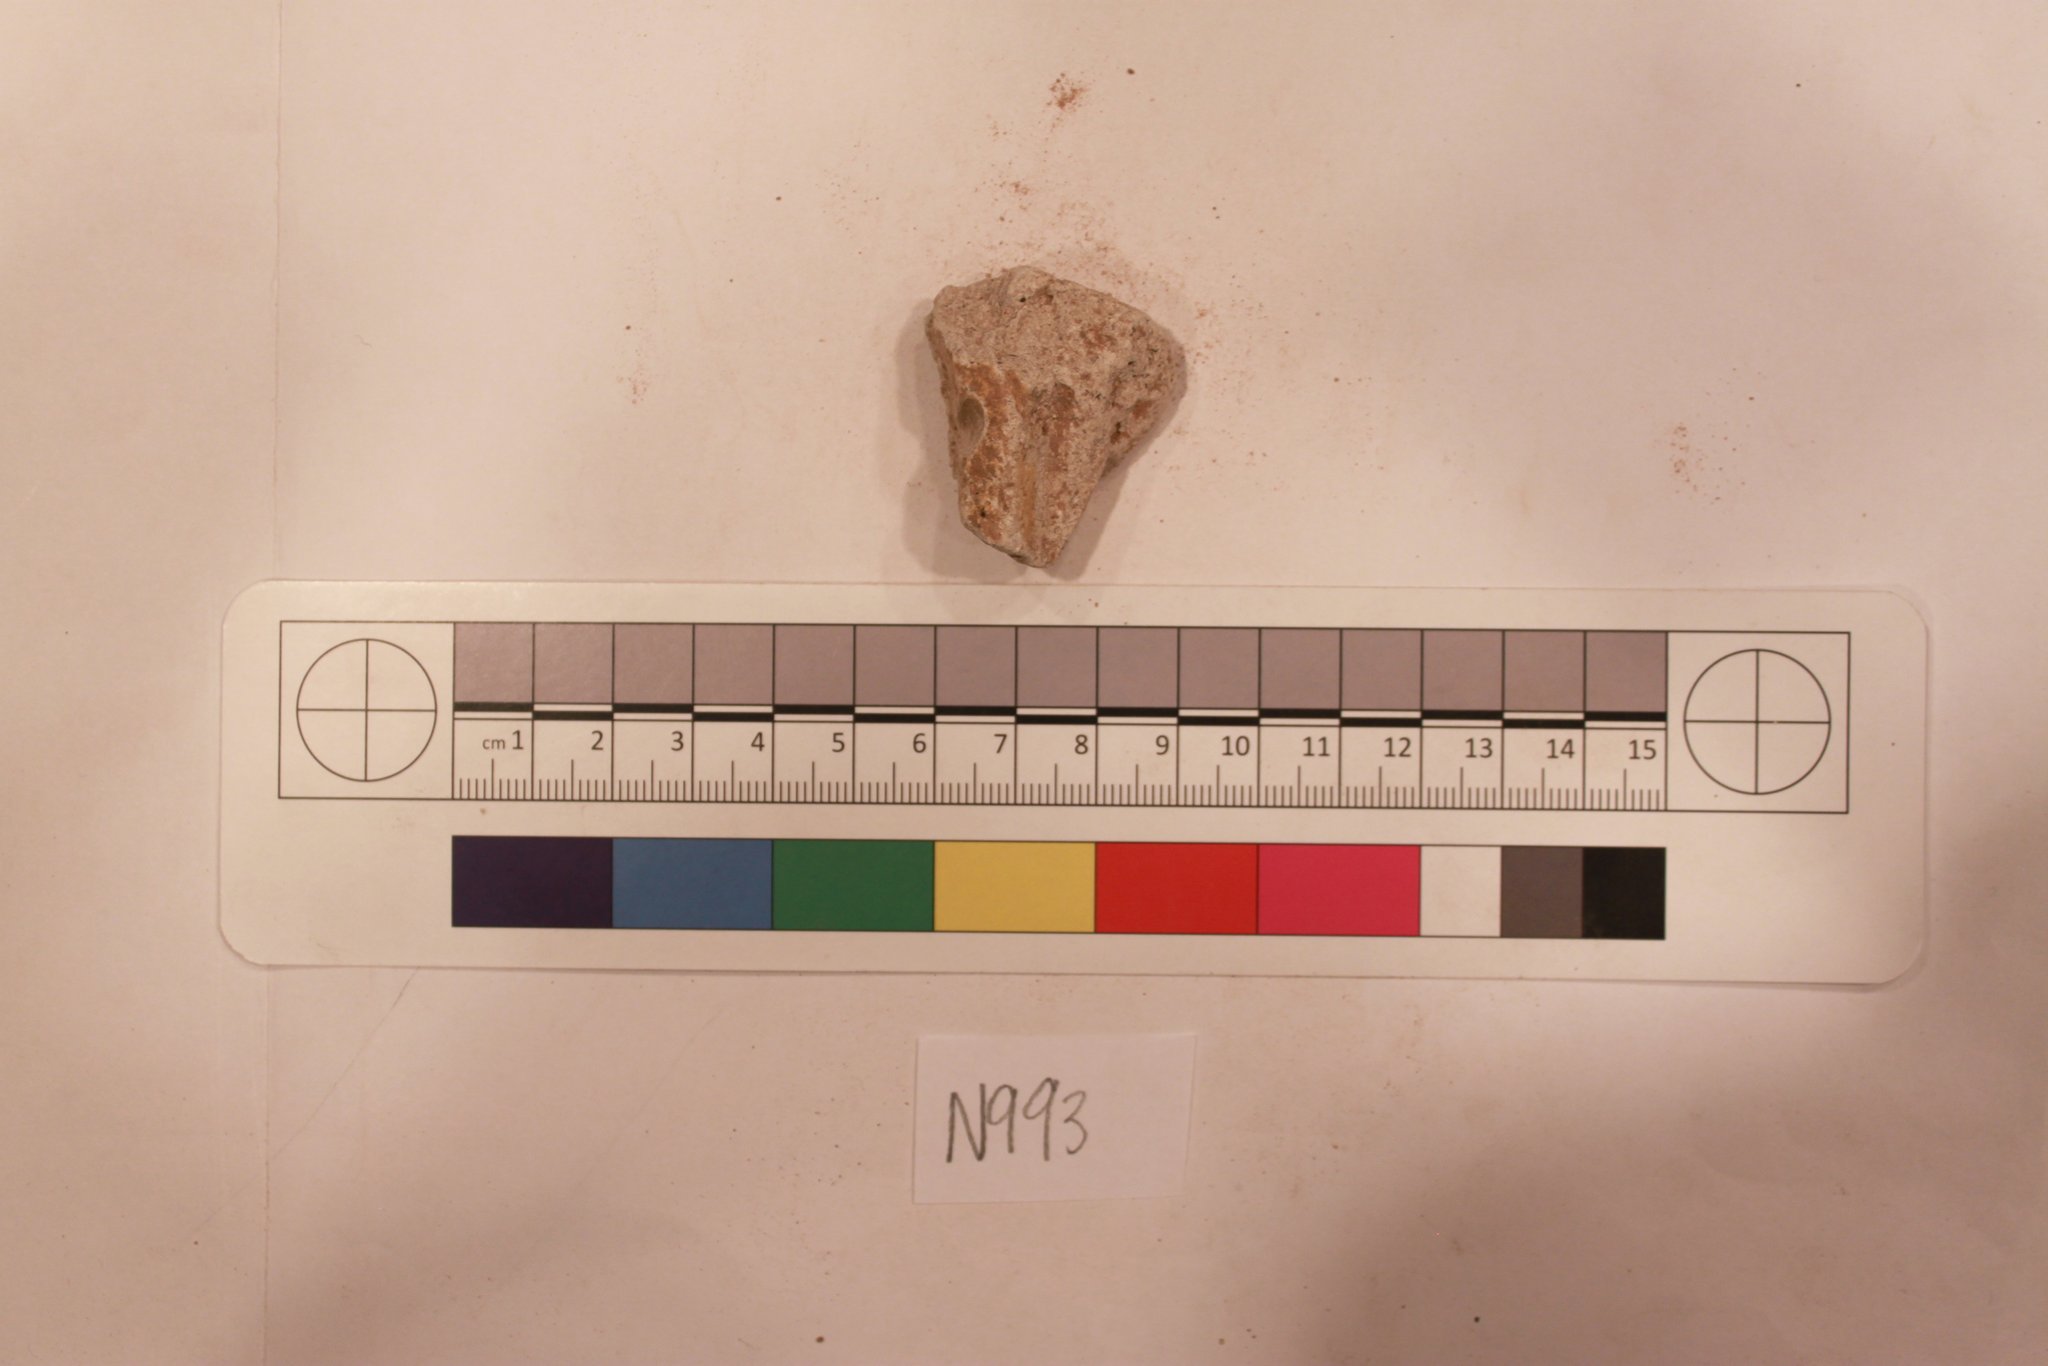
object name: fragment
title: Stucco Fragment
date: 701-1200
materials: plaster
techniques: carving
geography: iran